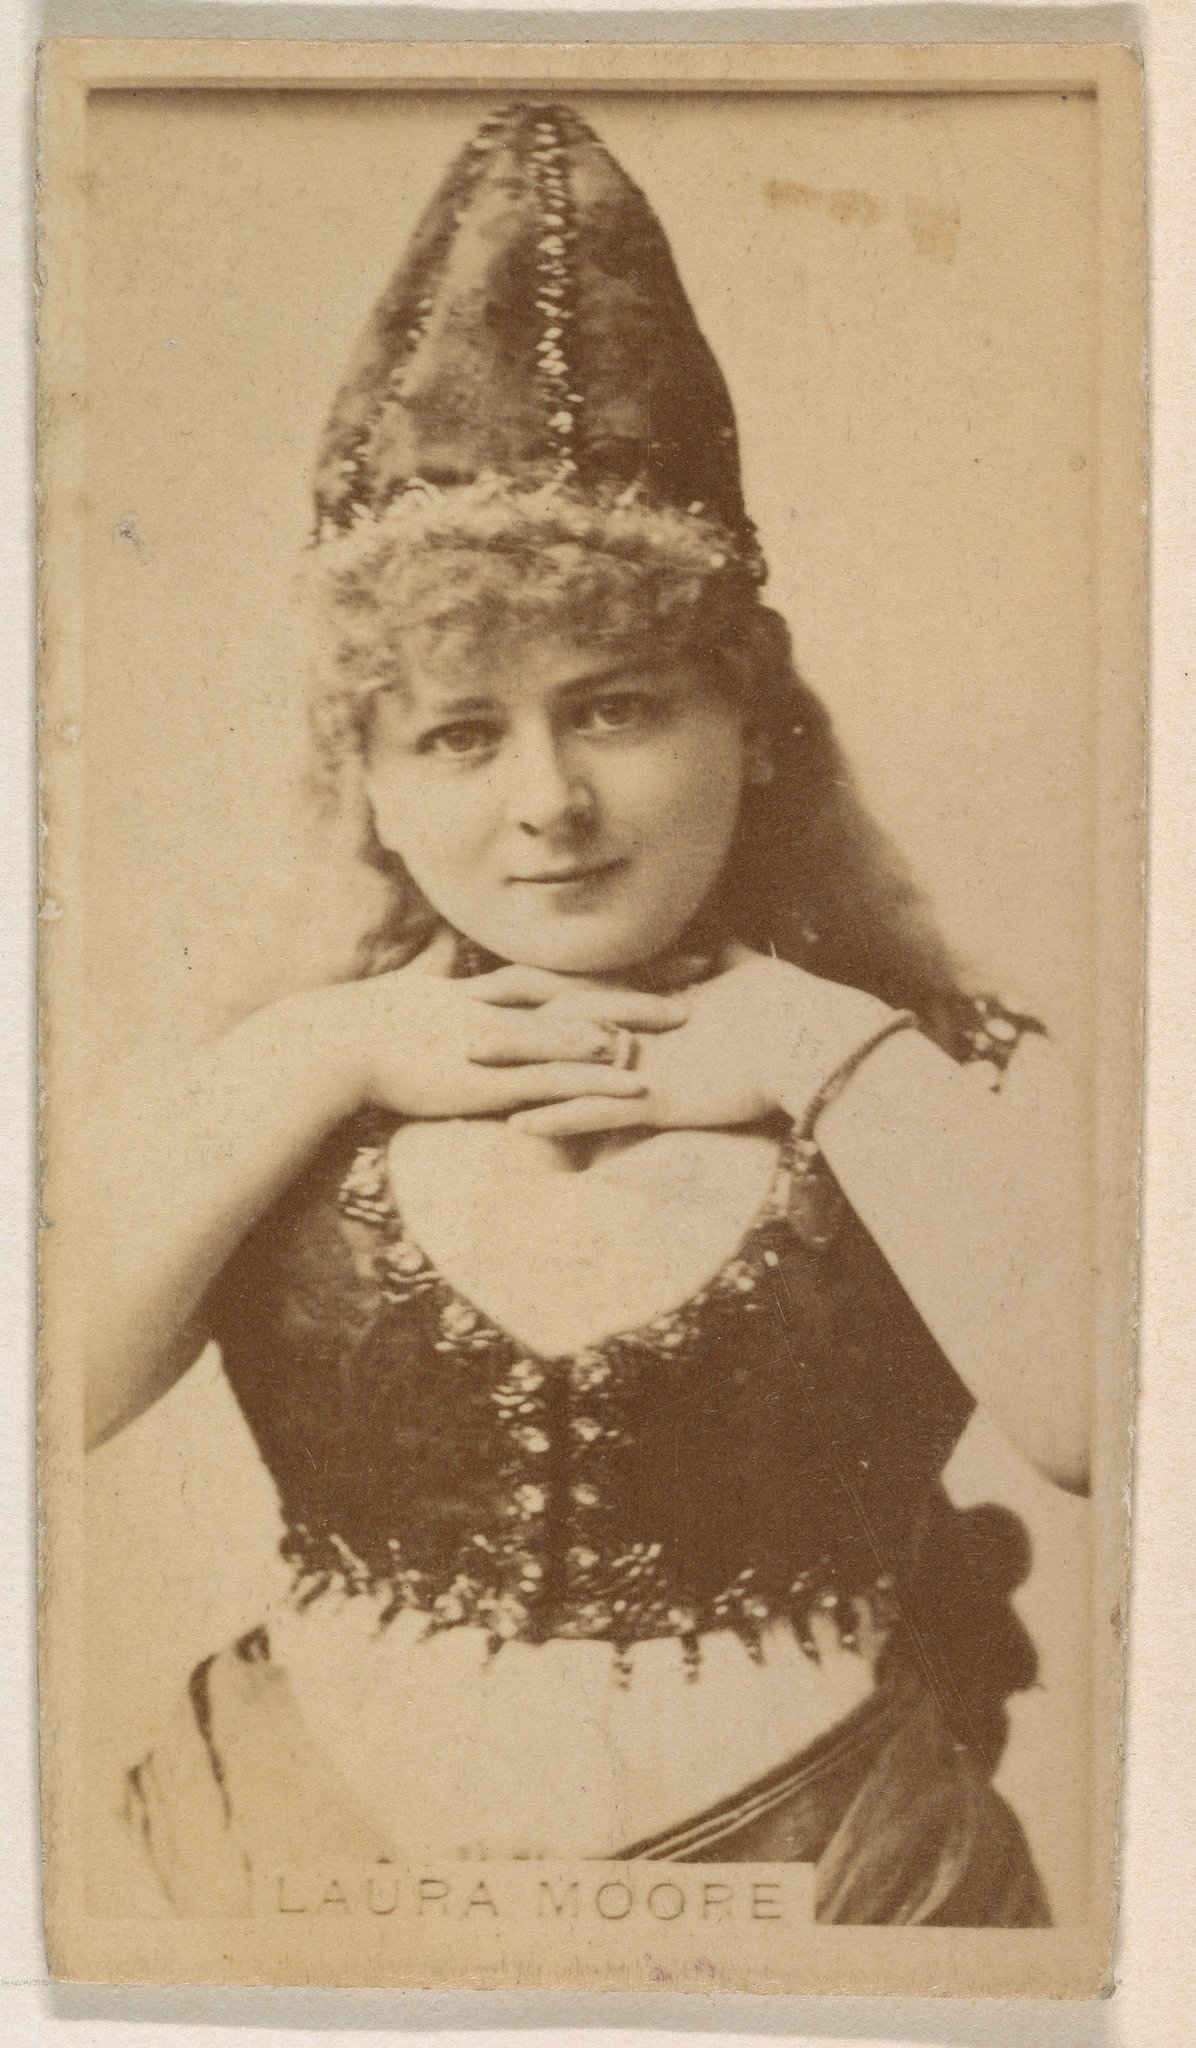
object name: photograph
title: Laura Moore, from the Actresses series (N245) issued by Kinney Brothers to promote Sweet Caporal Cigarettes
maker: kinney brothers tobacco company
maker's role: publisher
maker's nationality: american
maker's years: 1869-2011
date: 1890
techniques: albumen silver print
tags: portraits,women,actresses